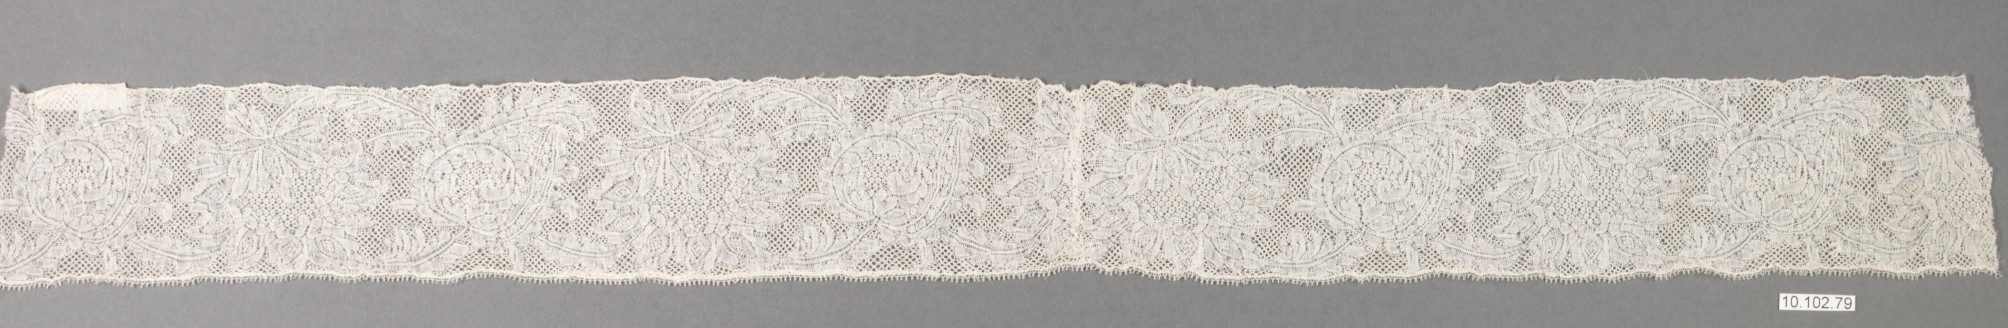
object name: strip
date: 1701-1733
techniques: lace